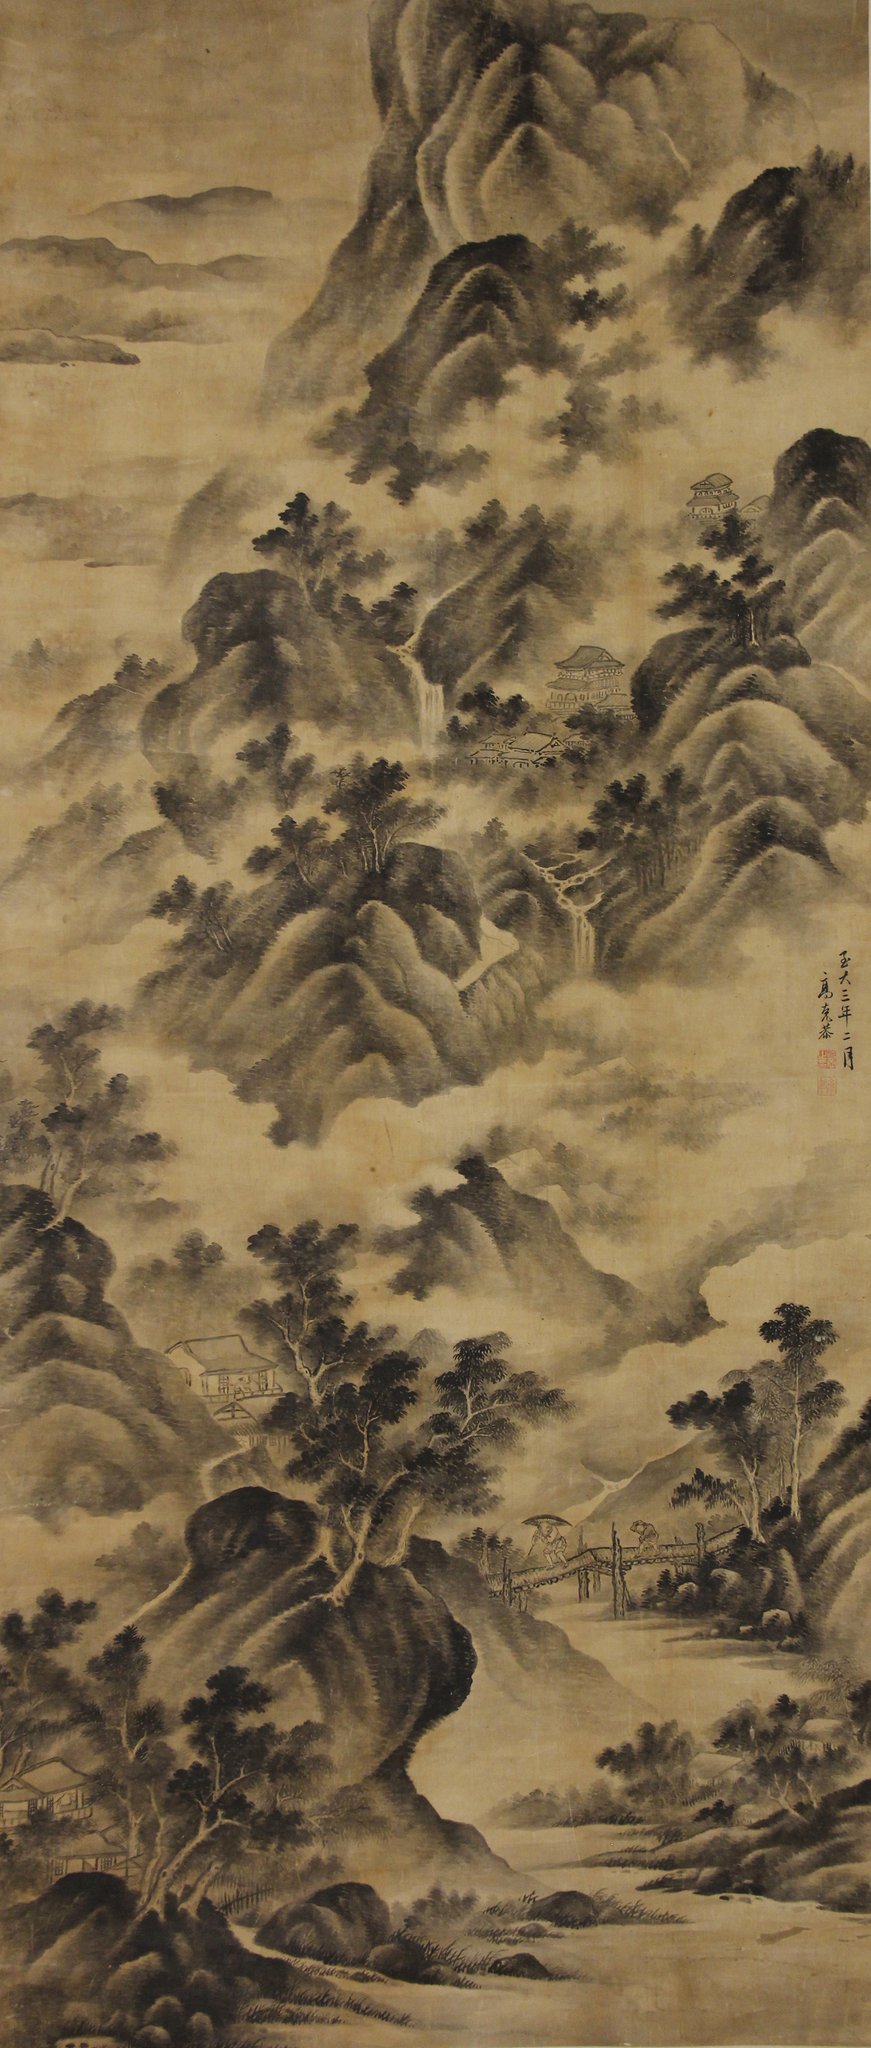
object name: hanging scroll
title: Landscape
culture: chinese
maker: unidentified artist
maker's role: artist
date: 1368-1911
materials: ink, silk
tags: mountains,landscapes